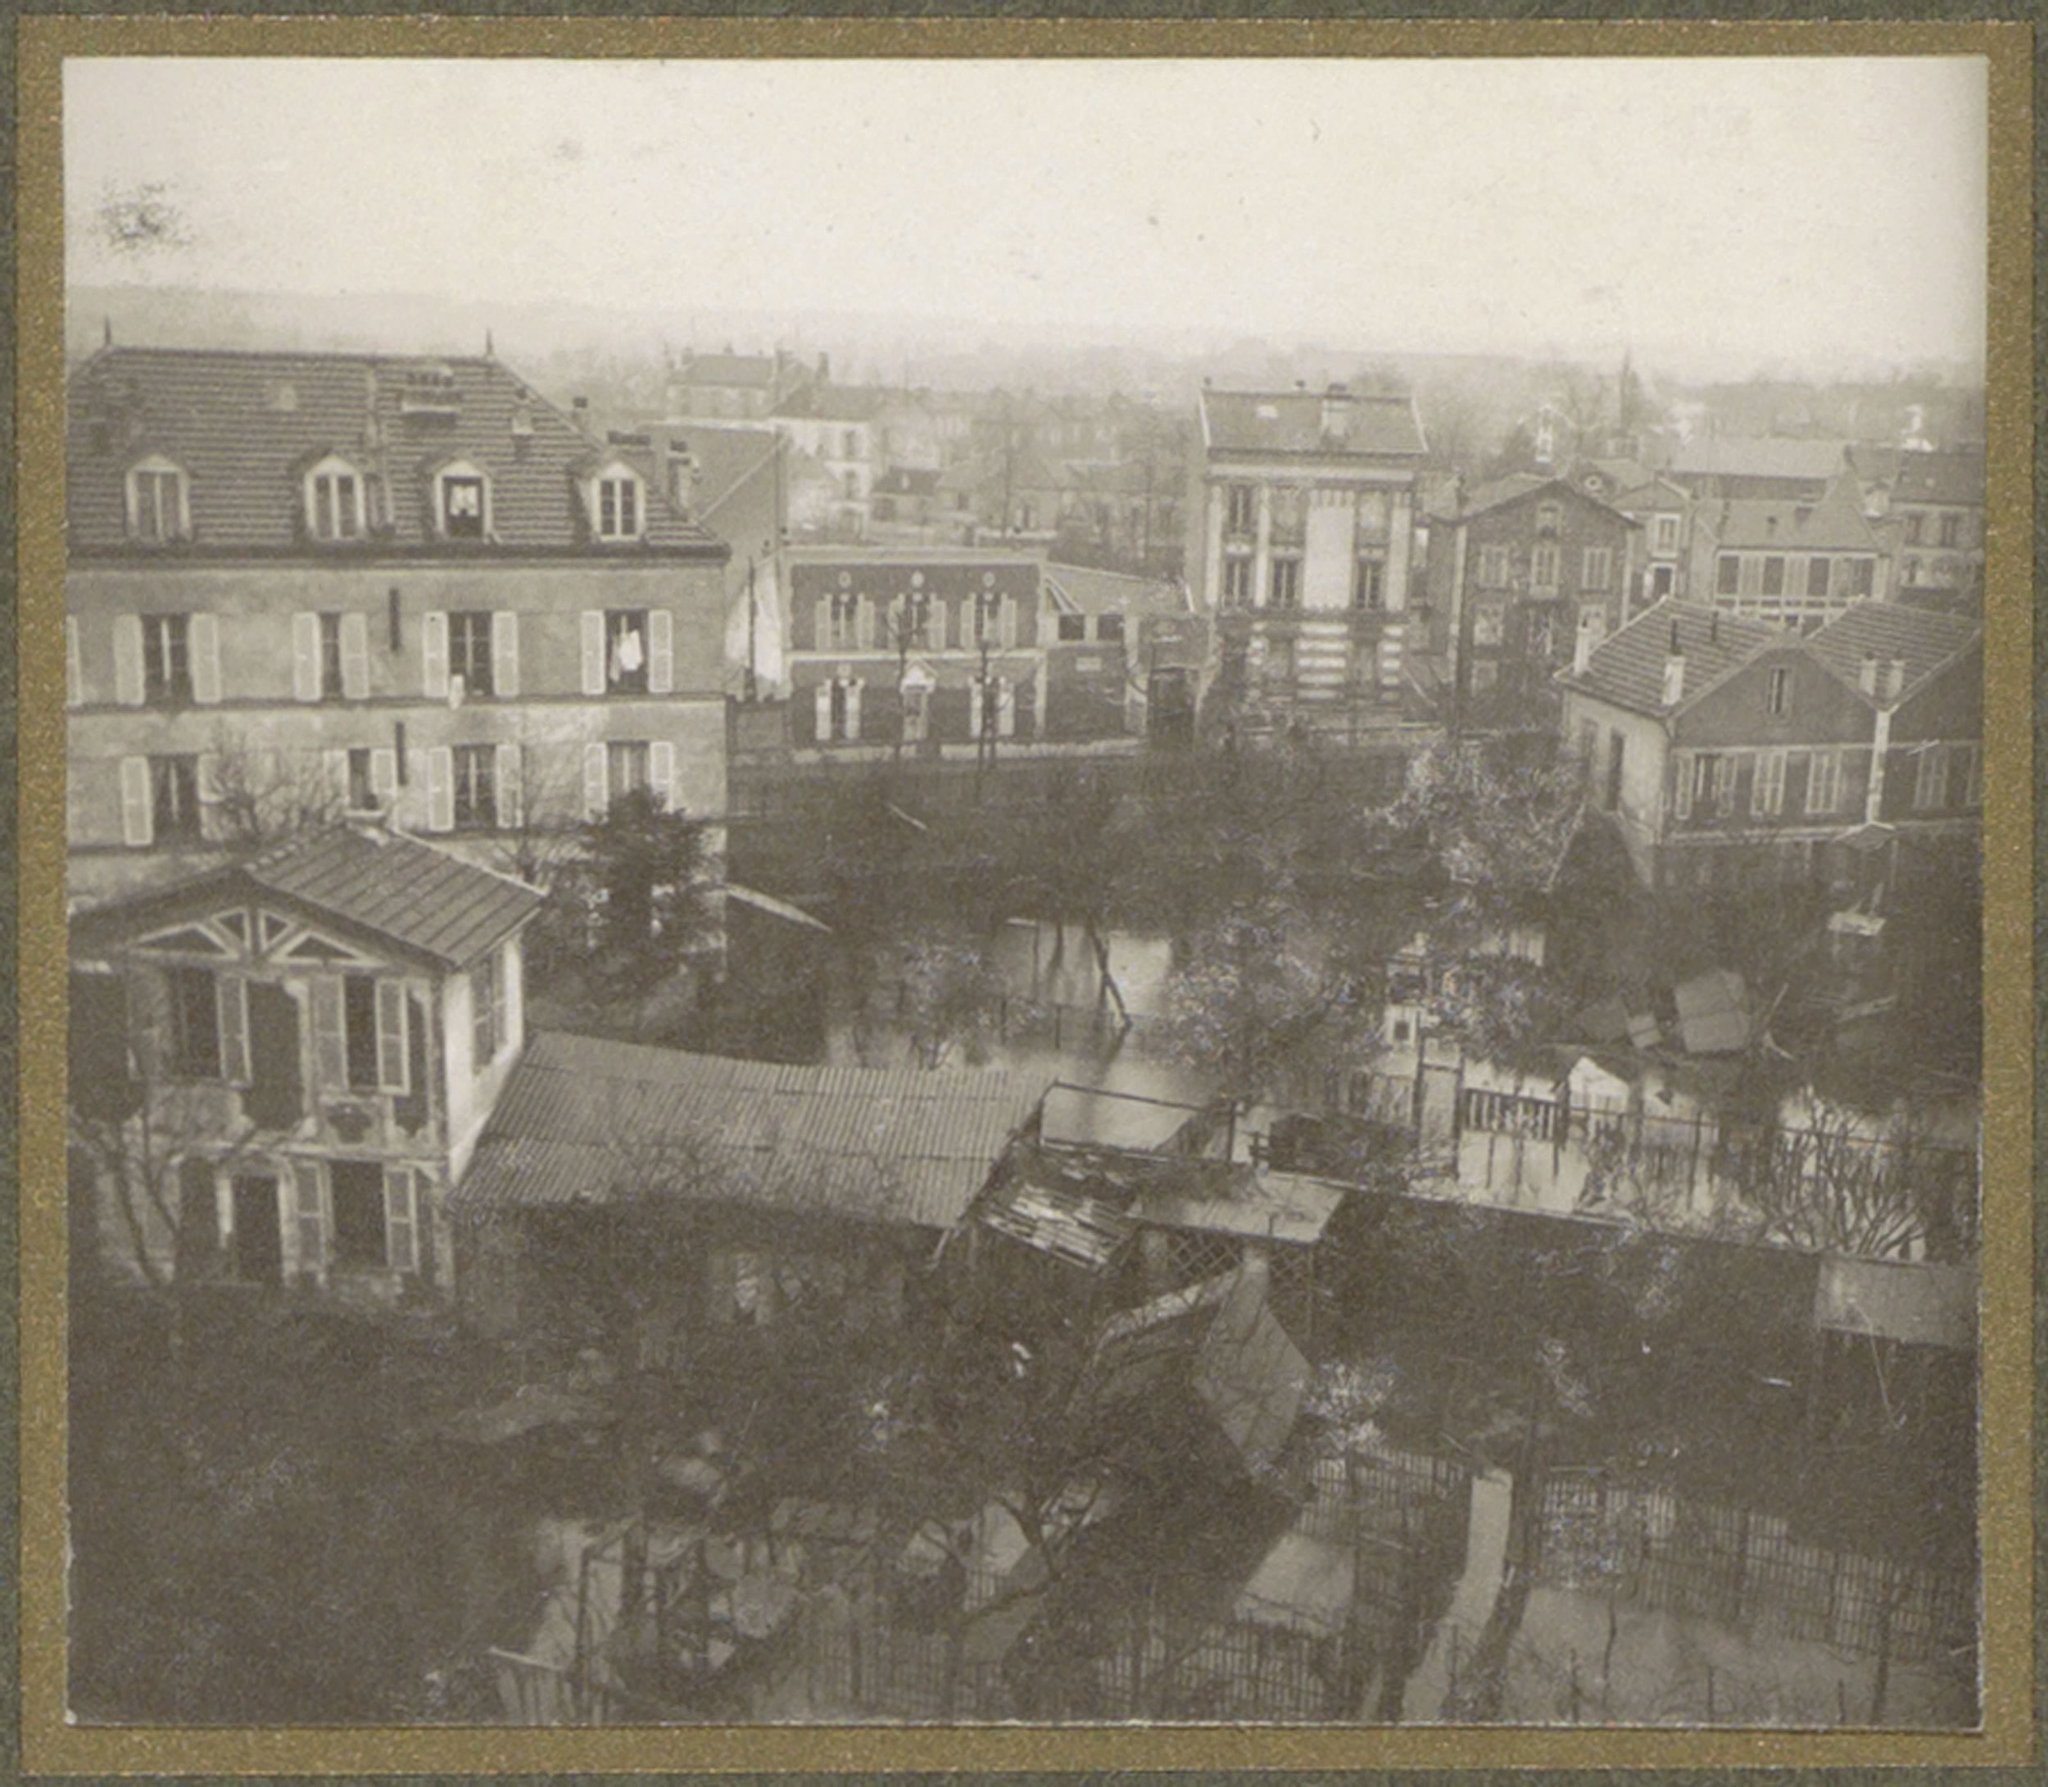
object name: photograph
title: Ondergelopen buitenwijk van Parijs gezien vanuit een venster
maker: g. dangereux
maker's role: fotograaf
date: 1901-1910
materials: photographic support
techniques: matte daylight collodion silver print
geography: paris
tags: flood (+ landscape with figures, staffage), paris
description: Onderdeel van fotoalbum overstroming Parijs en voorsteden 1910.